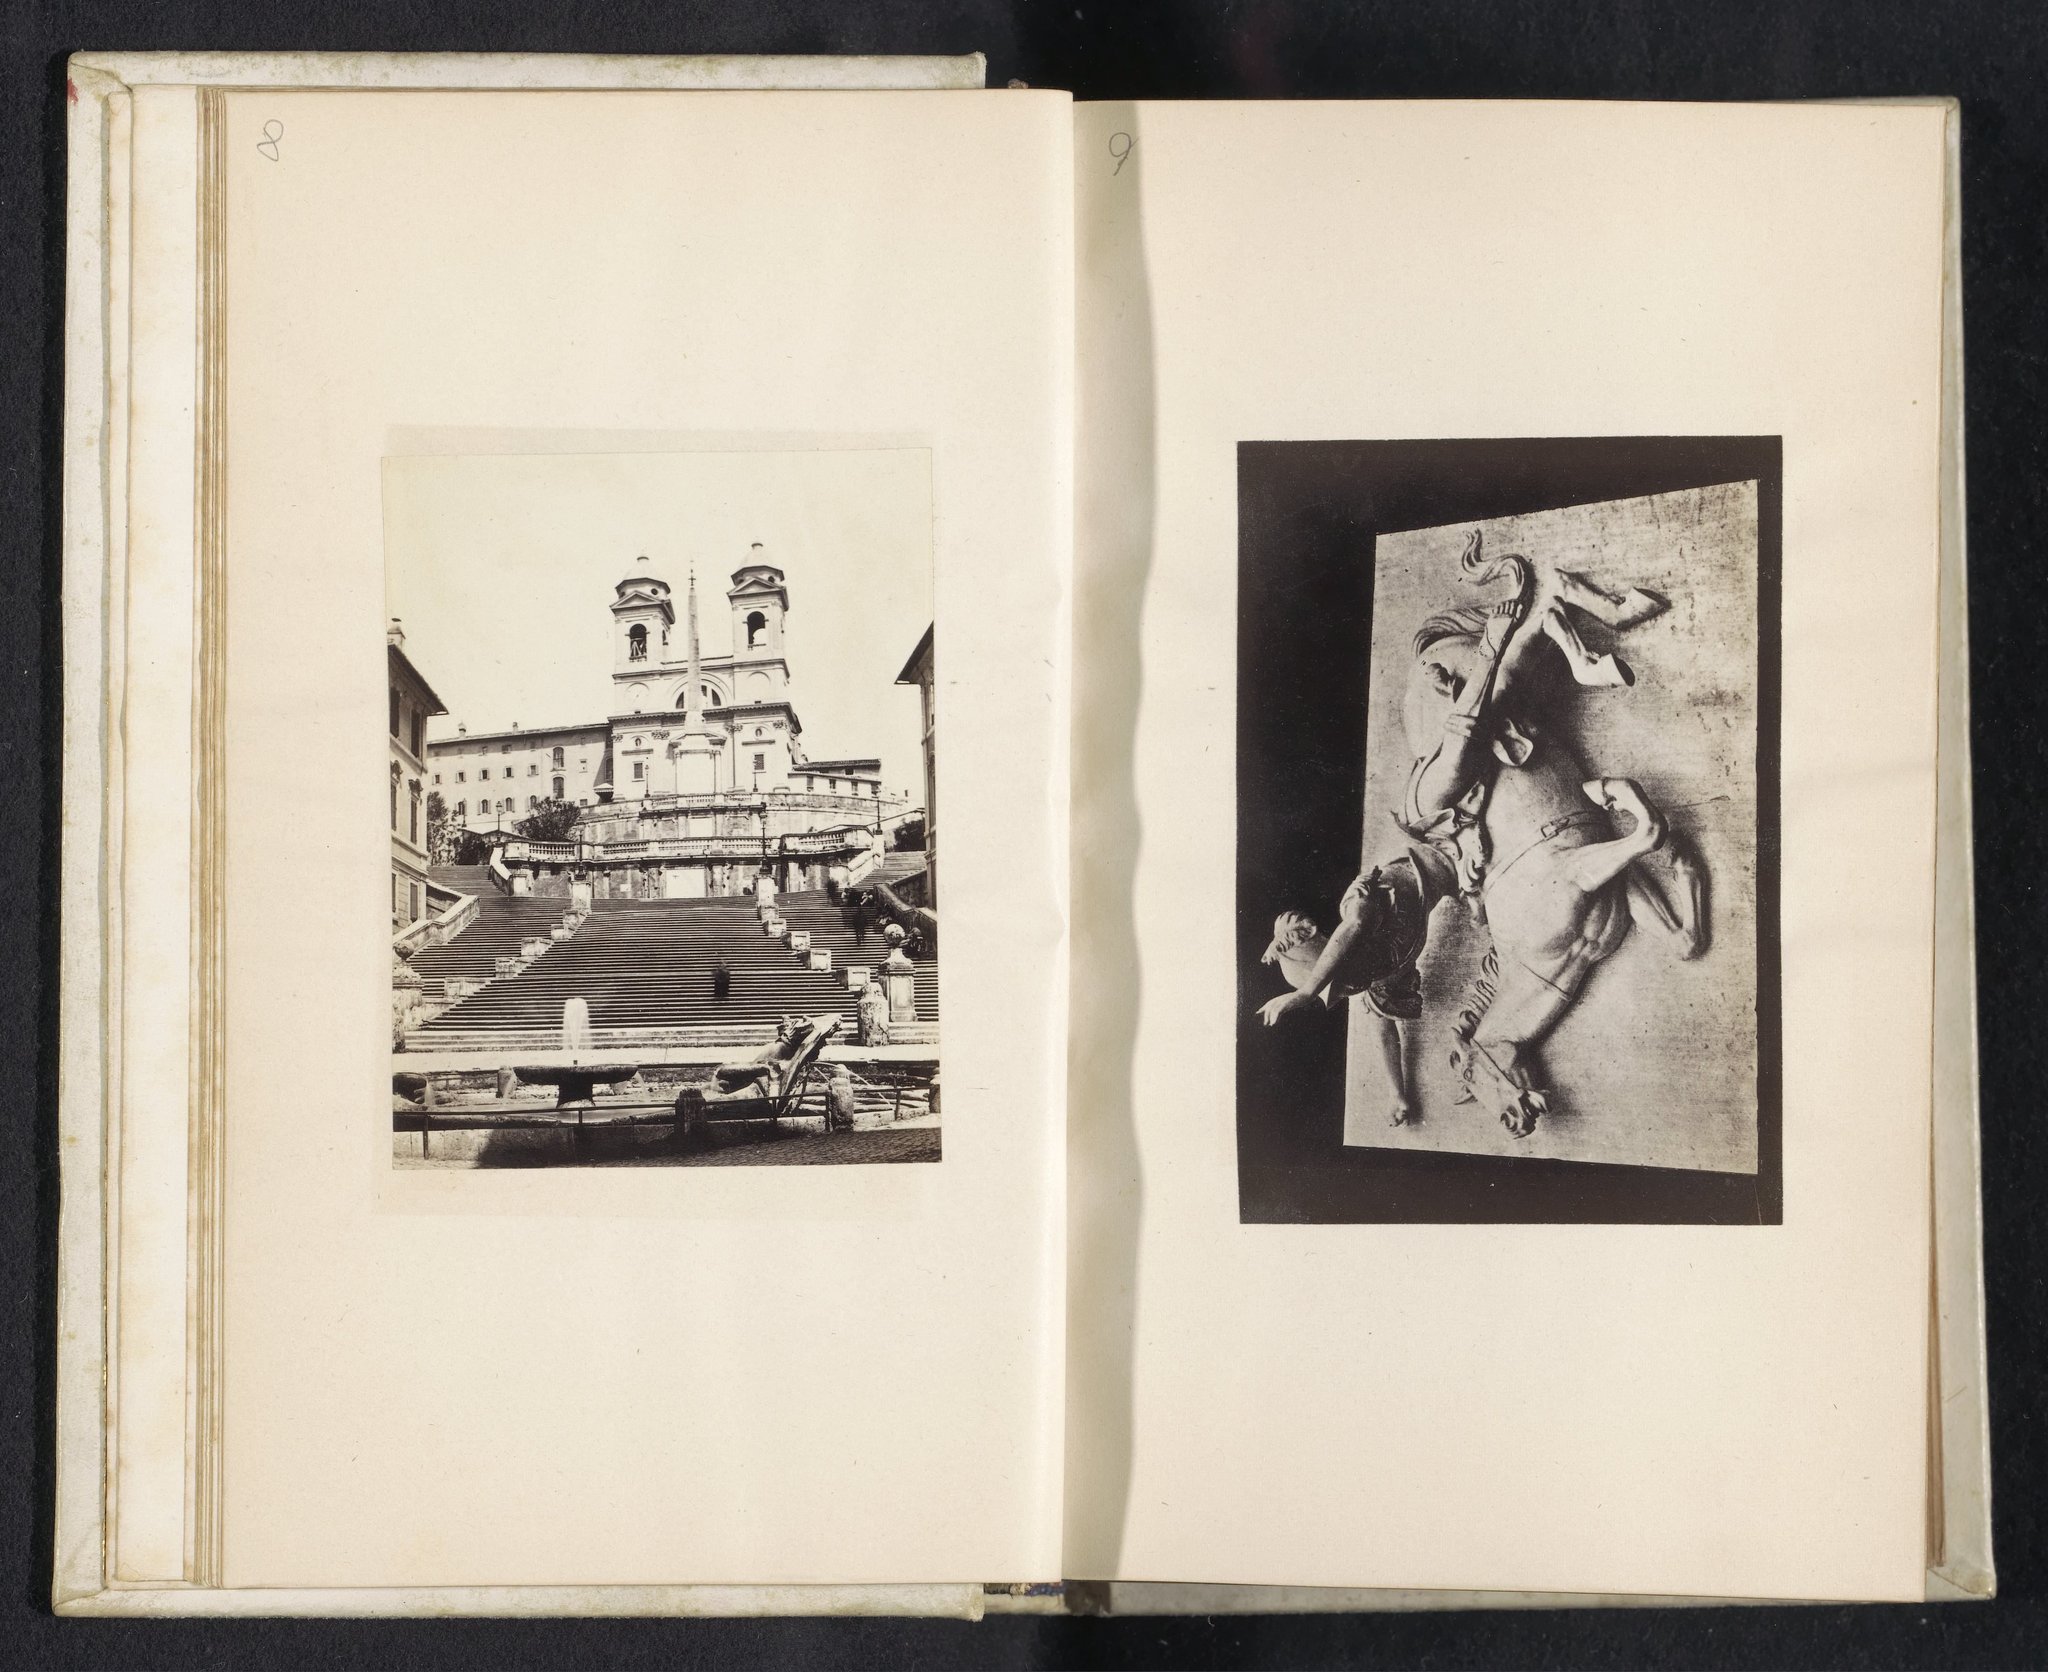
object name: photograph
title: Reliëf, voorstellende een man te paard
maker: Anonymous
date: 1850-1860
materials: photographic support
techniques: albumen print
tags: riding a horse, ass, or mule; rider, horseman, sculpture (+ relief ~ sculpture)